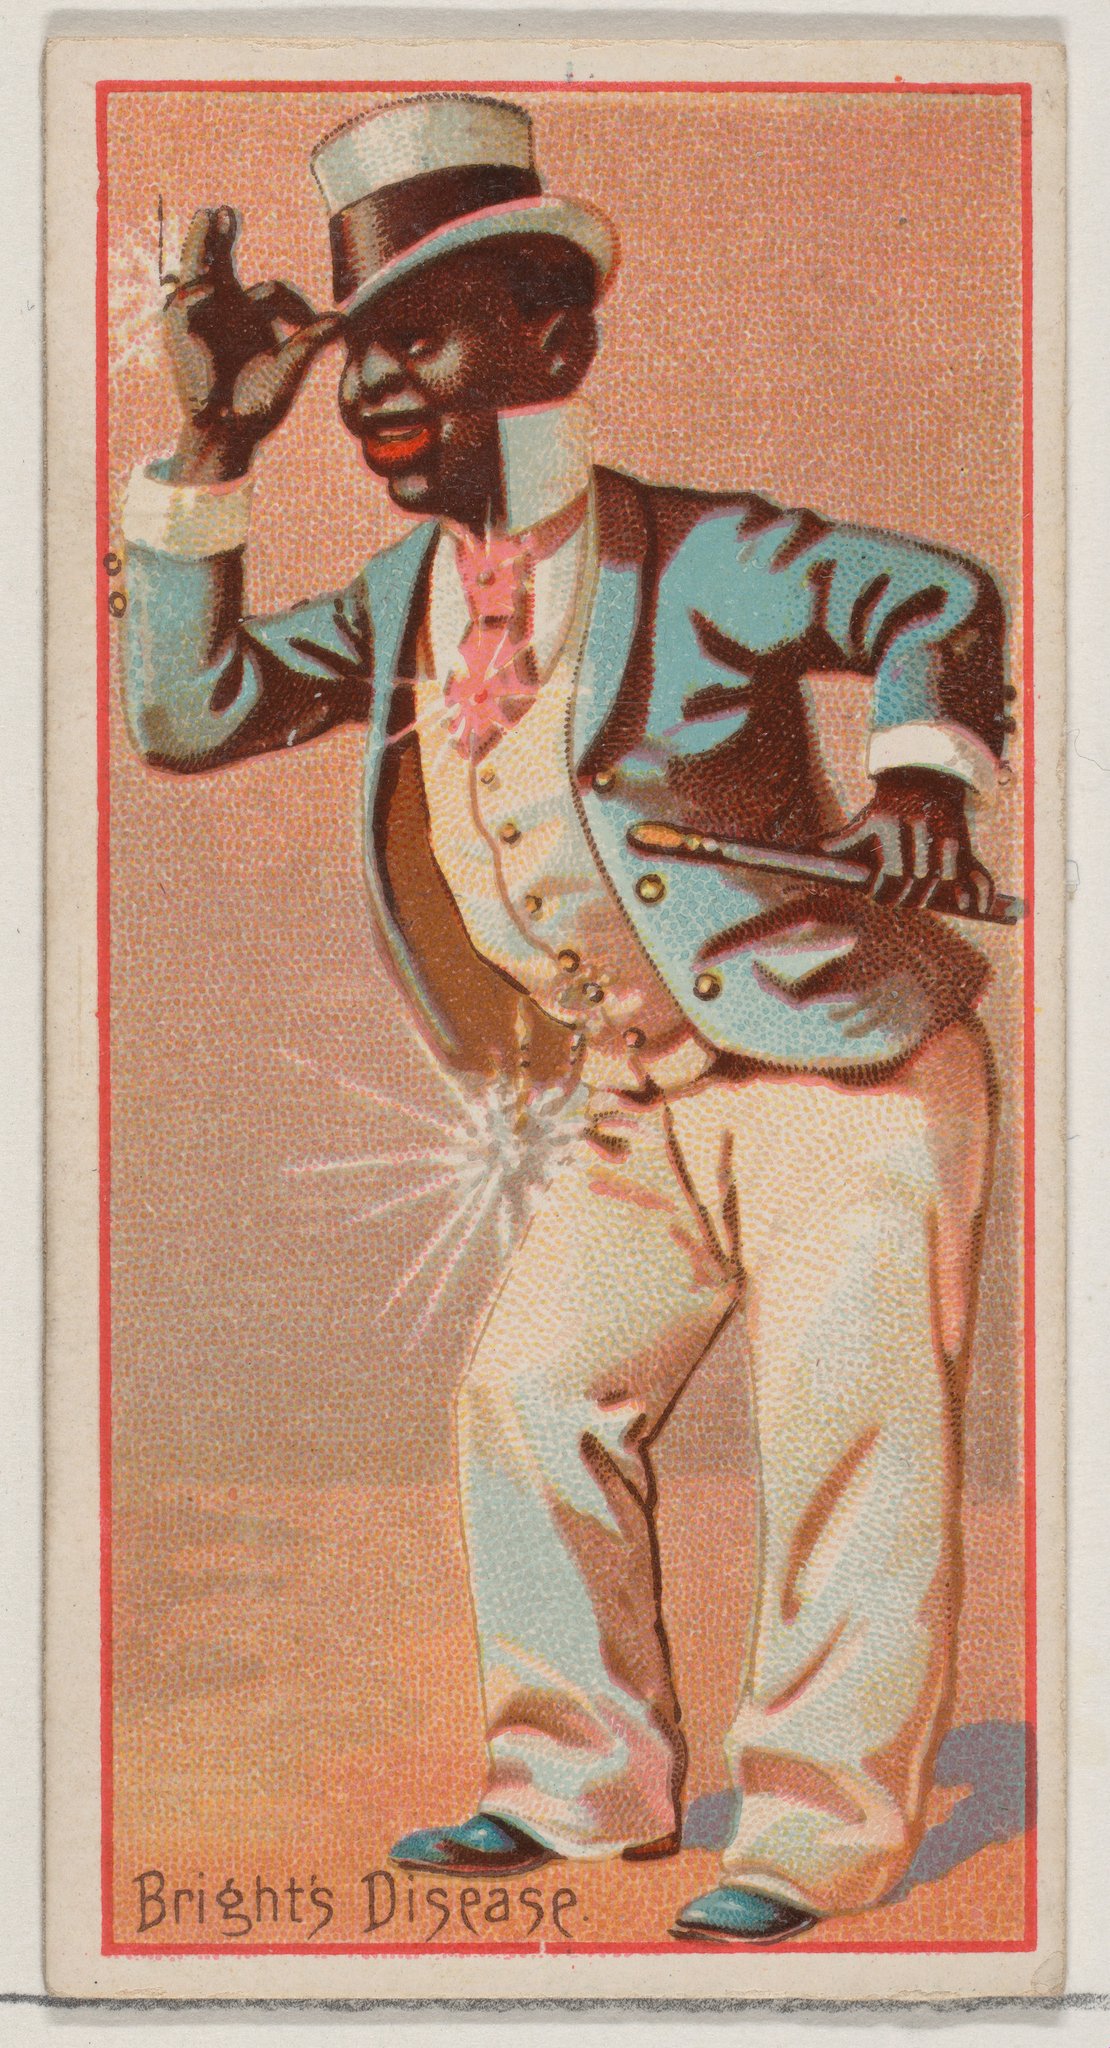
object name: print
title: Caricatured figure / Bright's Disease, from the Jokes series (N87) for Duke brand cigarettes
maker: w. duke, sons & co.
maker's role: publisher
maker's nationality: american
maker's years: 1870-1920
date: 1890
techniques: color lithograph